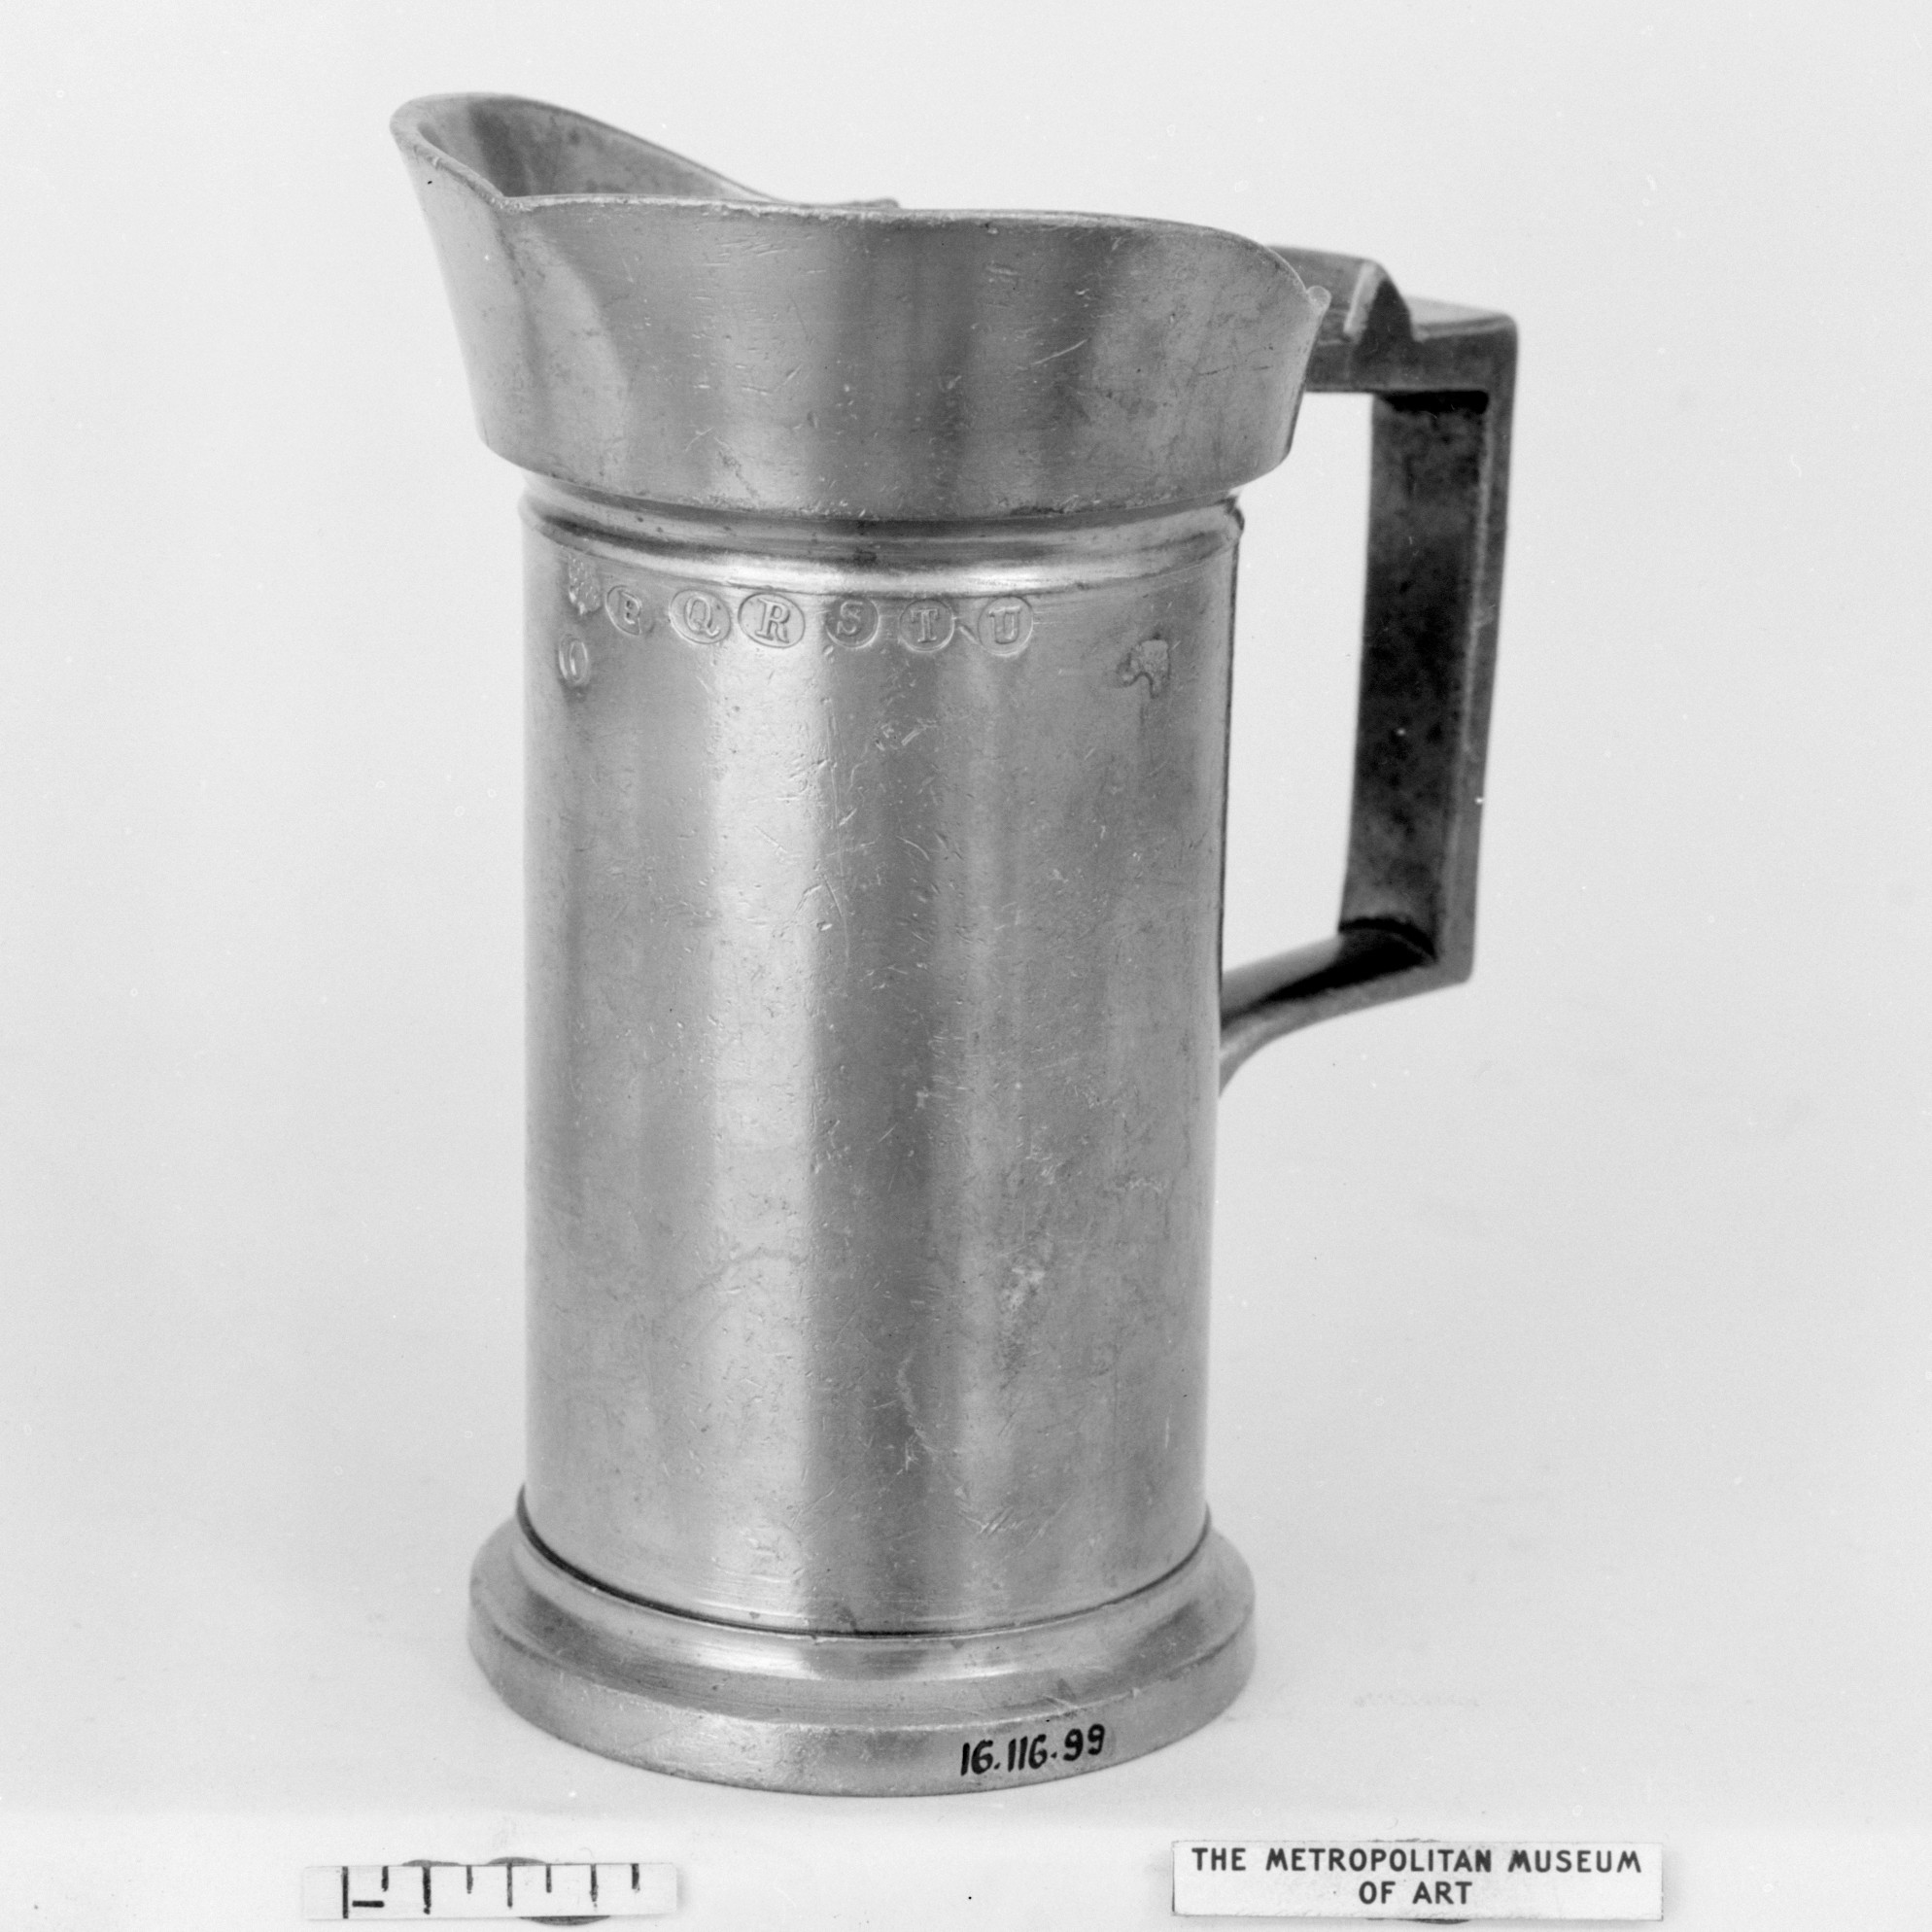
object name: measure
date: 1701-1733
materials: pewter